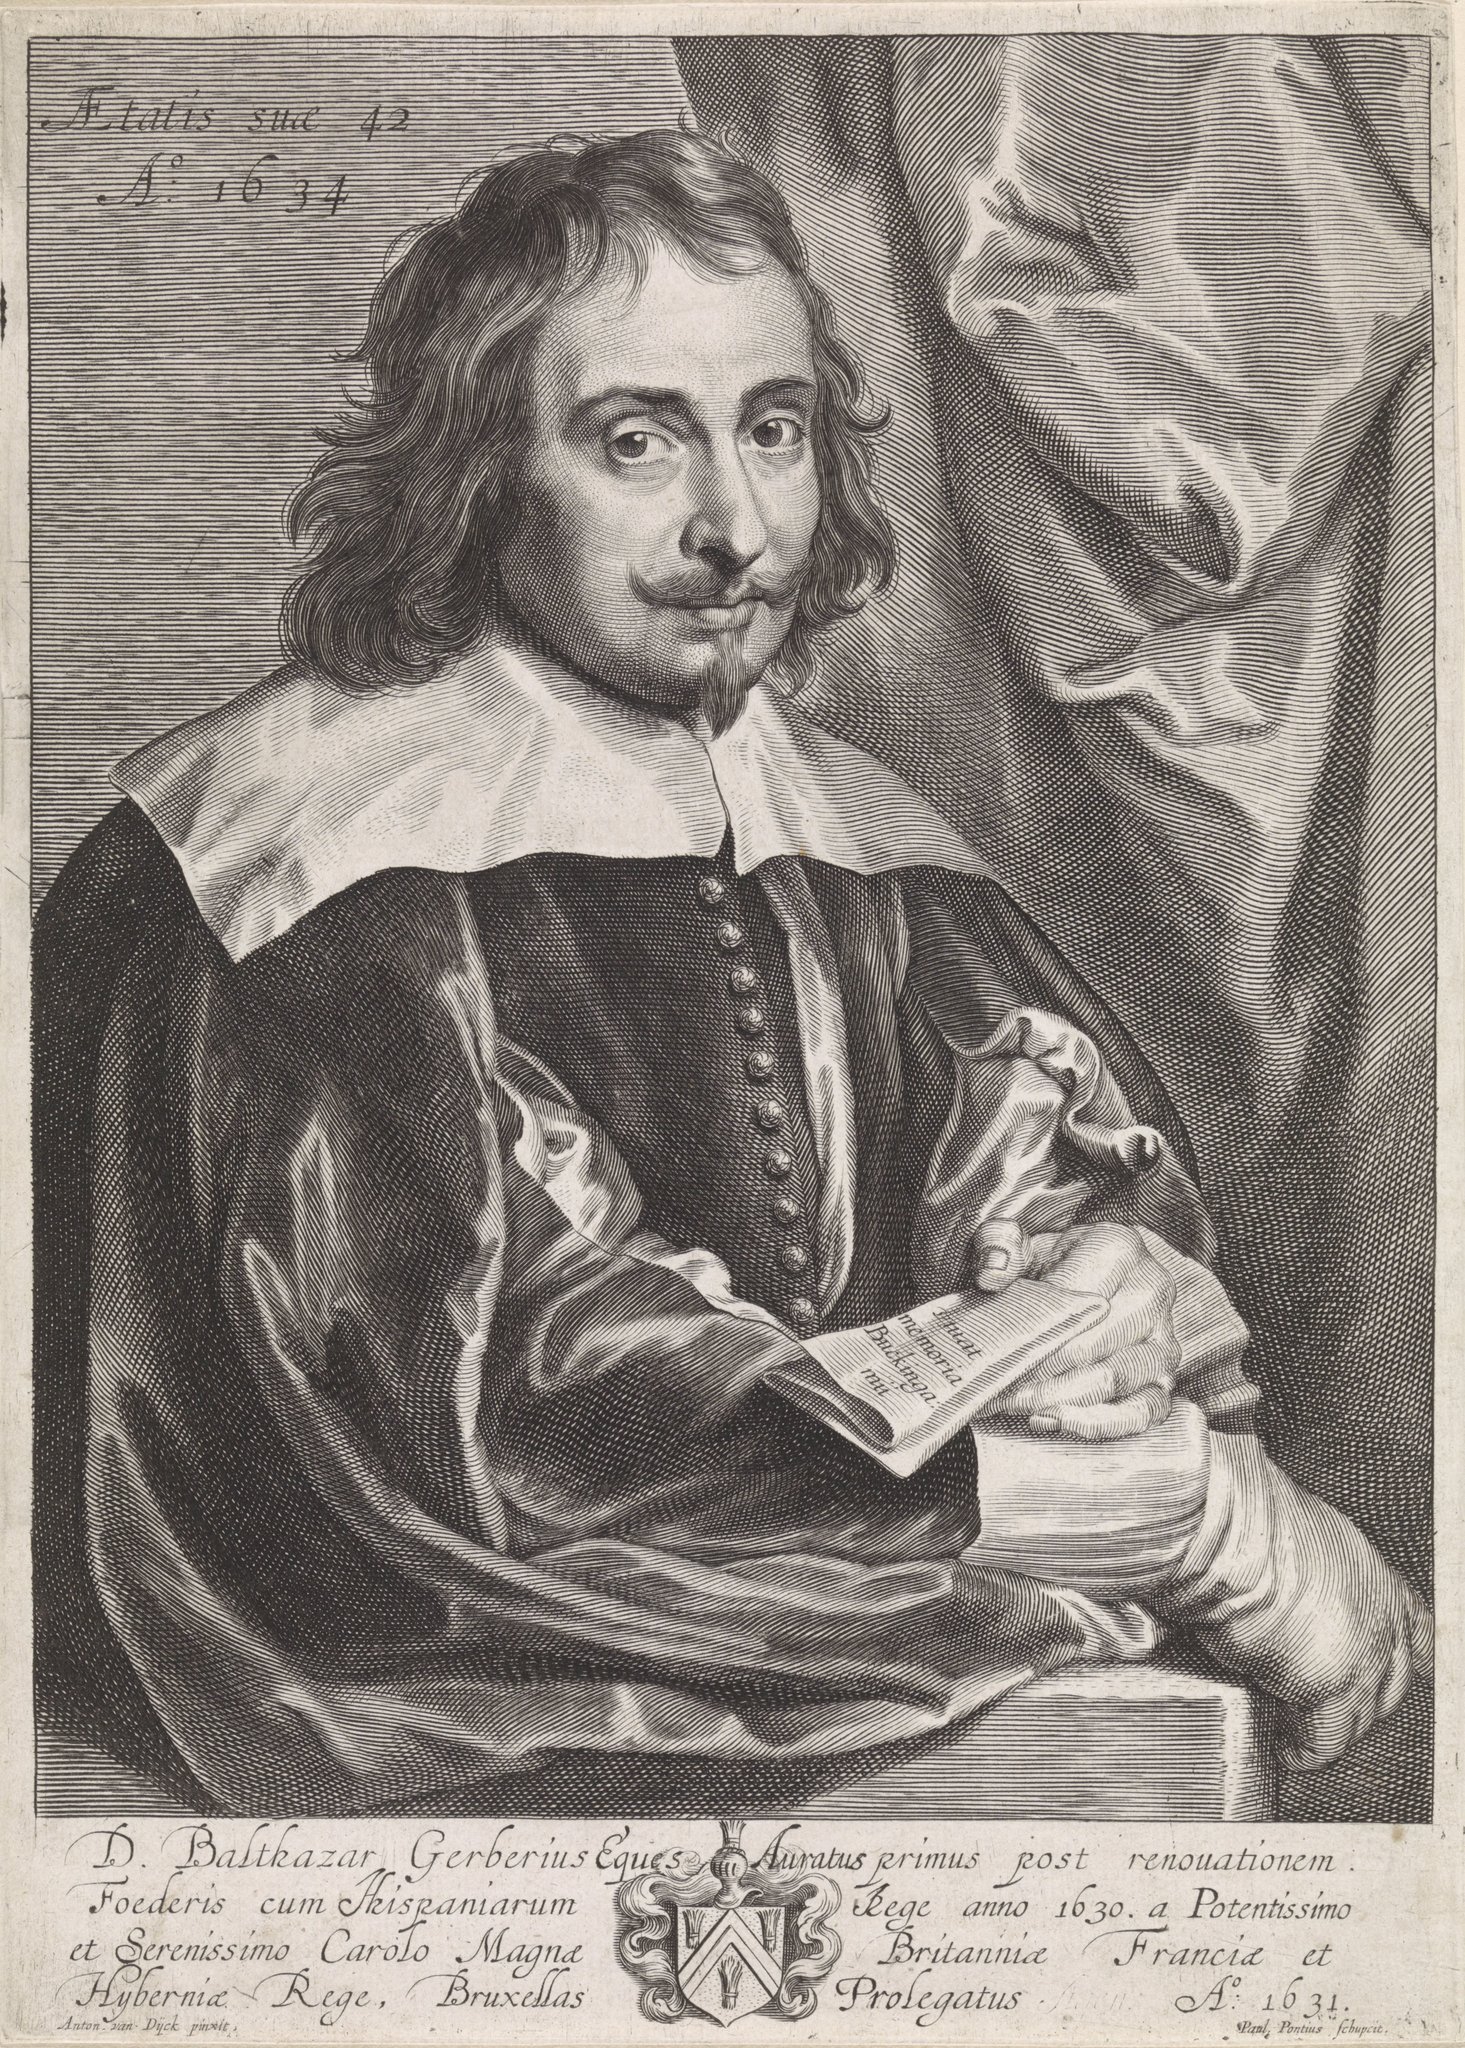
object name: print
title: Portret van Balthasar Gerbier, op 42-jarige leeftijd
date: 1634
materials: paper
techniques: engraving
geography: antwerp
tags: middelburg, draughtsman, balthazar gerbier d'ouvilly, letter, envelope, armorial bearing, heraldry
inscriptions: collector's mark: Lugt 240